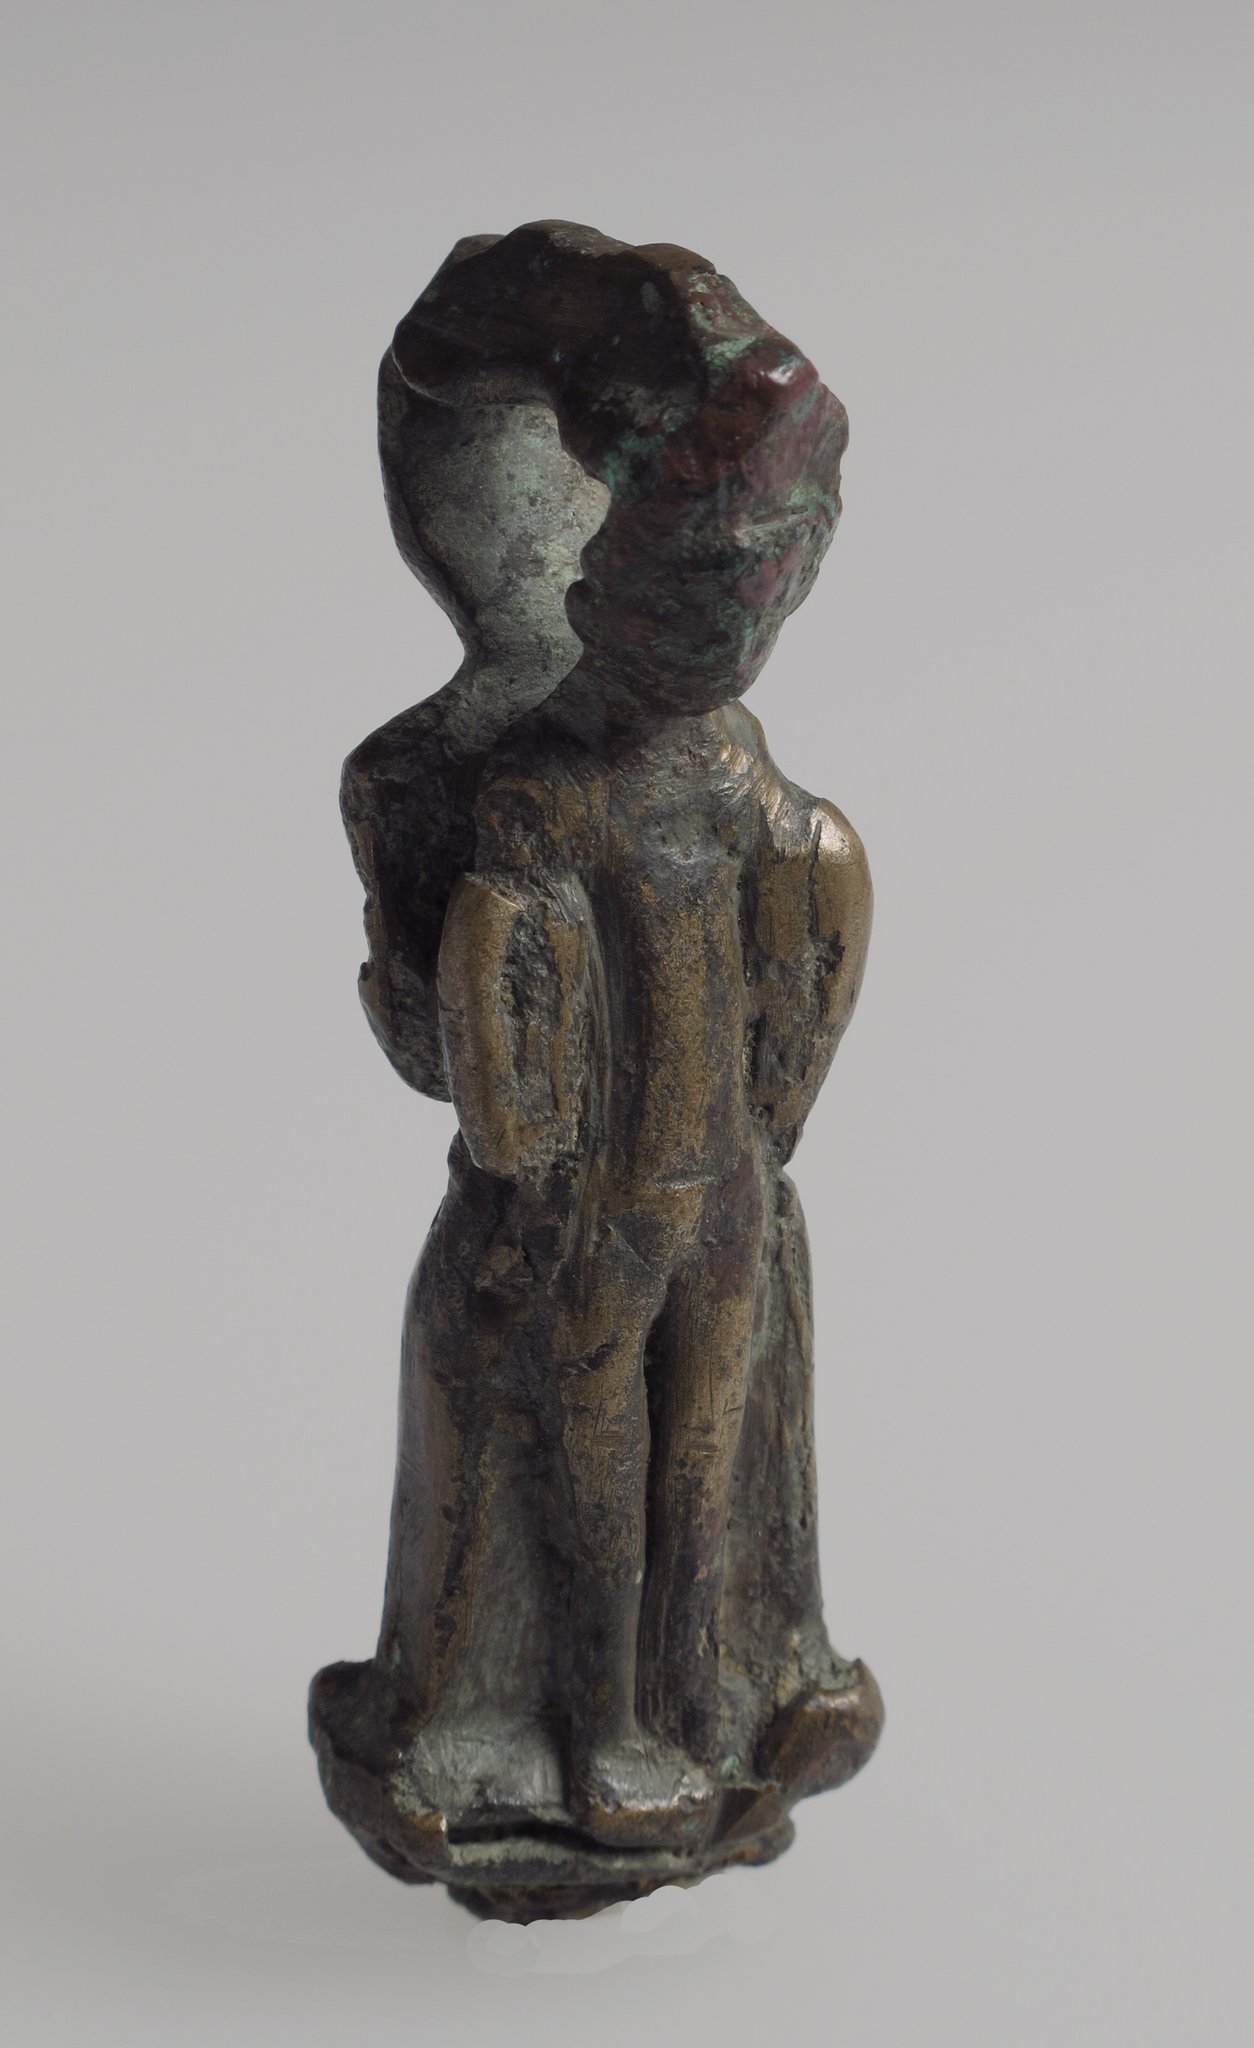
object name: key handle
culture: roman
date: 1-700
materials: copper alloy